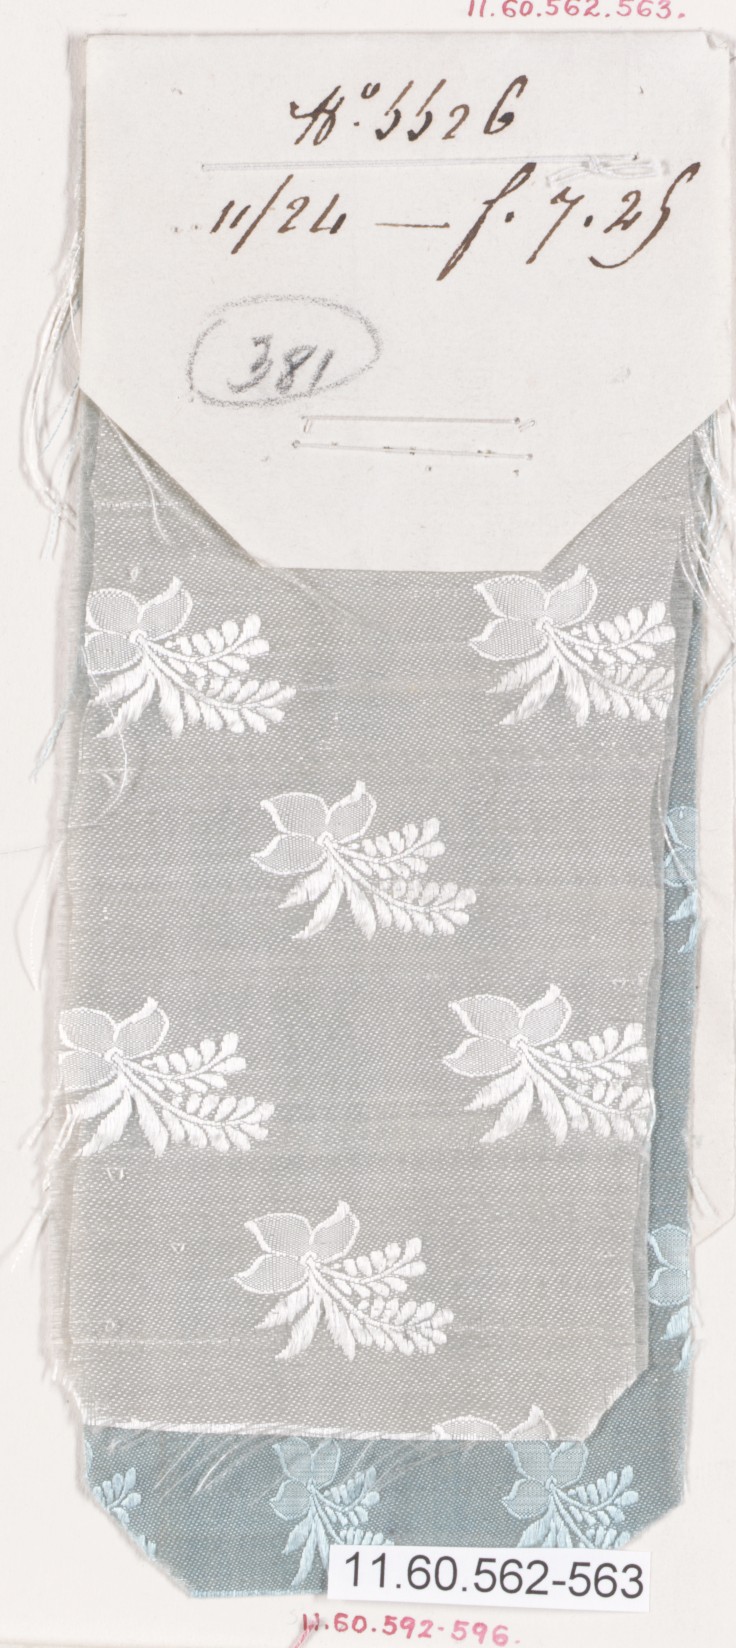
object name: sample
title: Samples (2)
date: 1801-1850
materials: silk